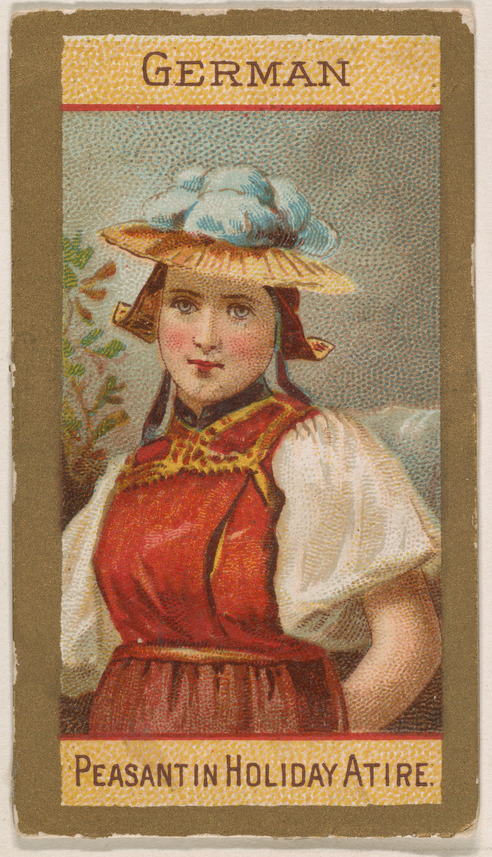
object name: print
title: German, Peasant in Holiday Attire, from Types of Nationalities (N240) issued by Kinney Bros.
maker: kinney brothers tobacco company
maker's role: publisher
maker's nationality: american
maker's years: 1869-2011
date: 1890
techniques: color lithograph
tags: women